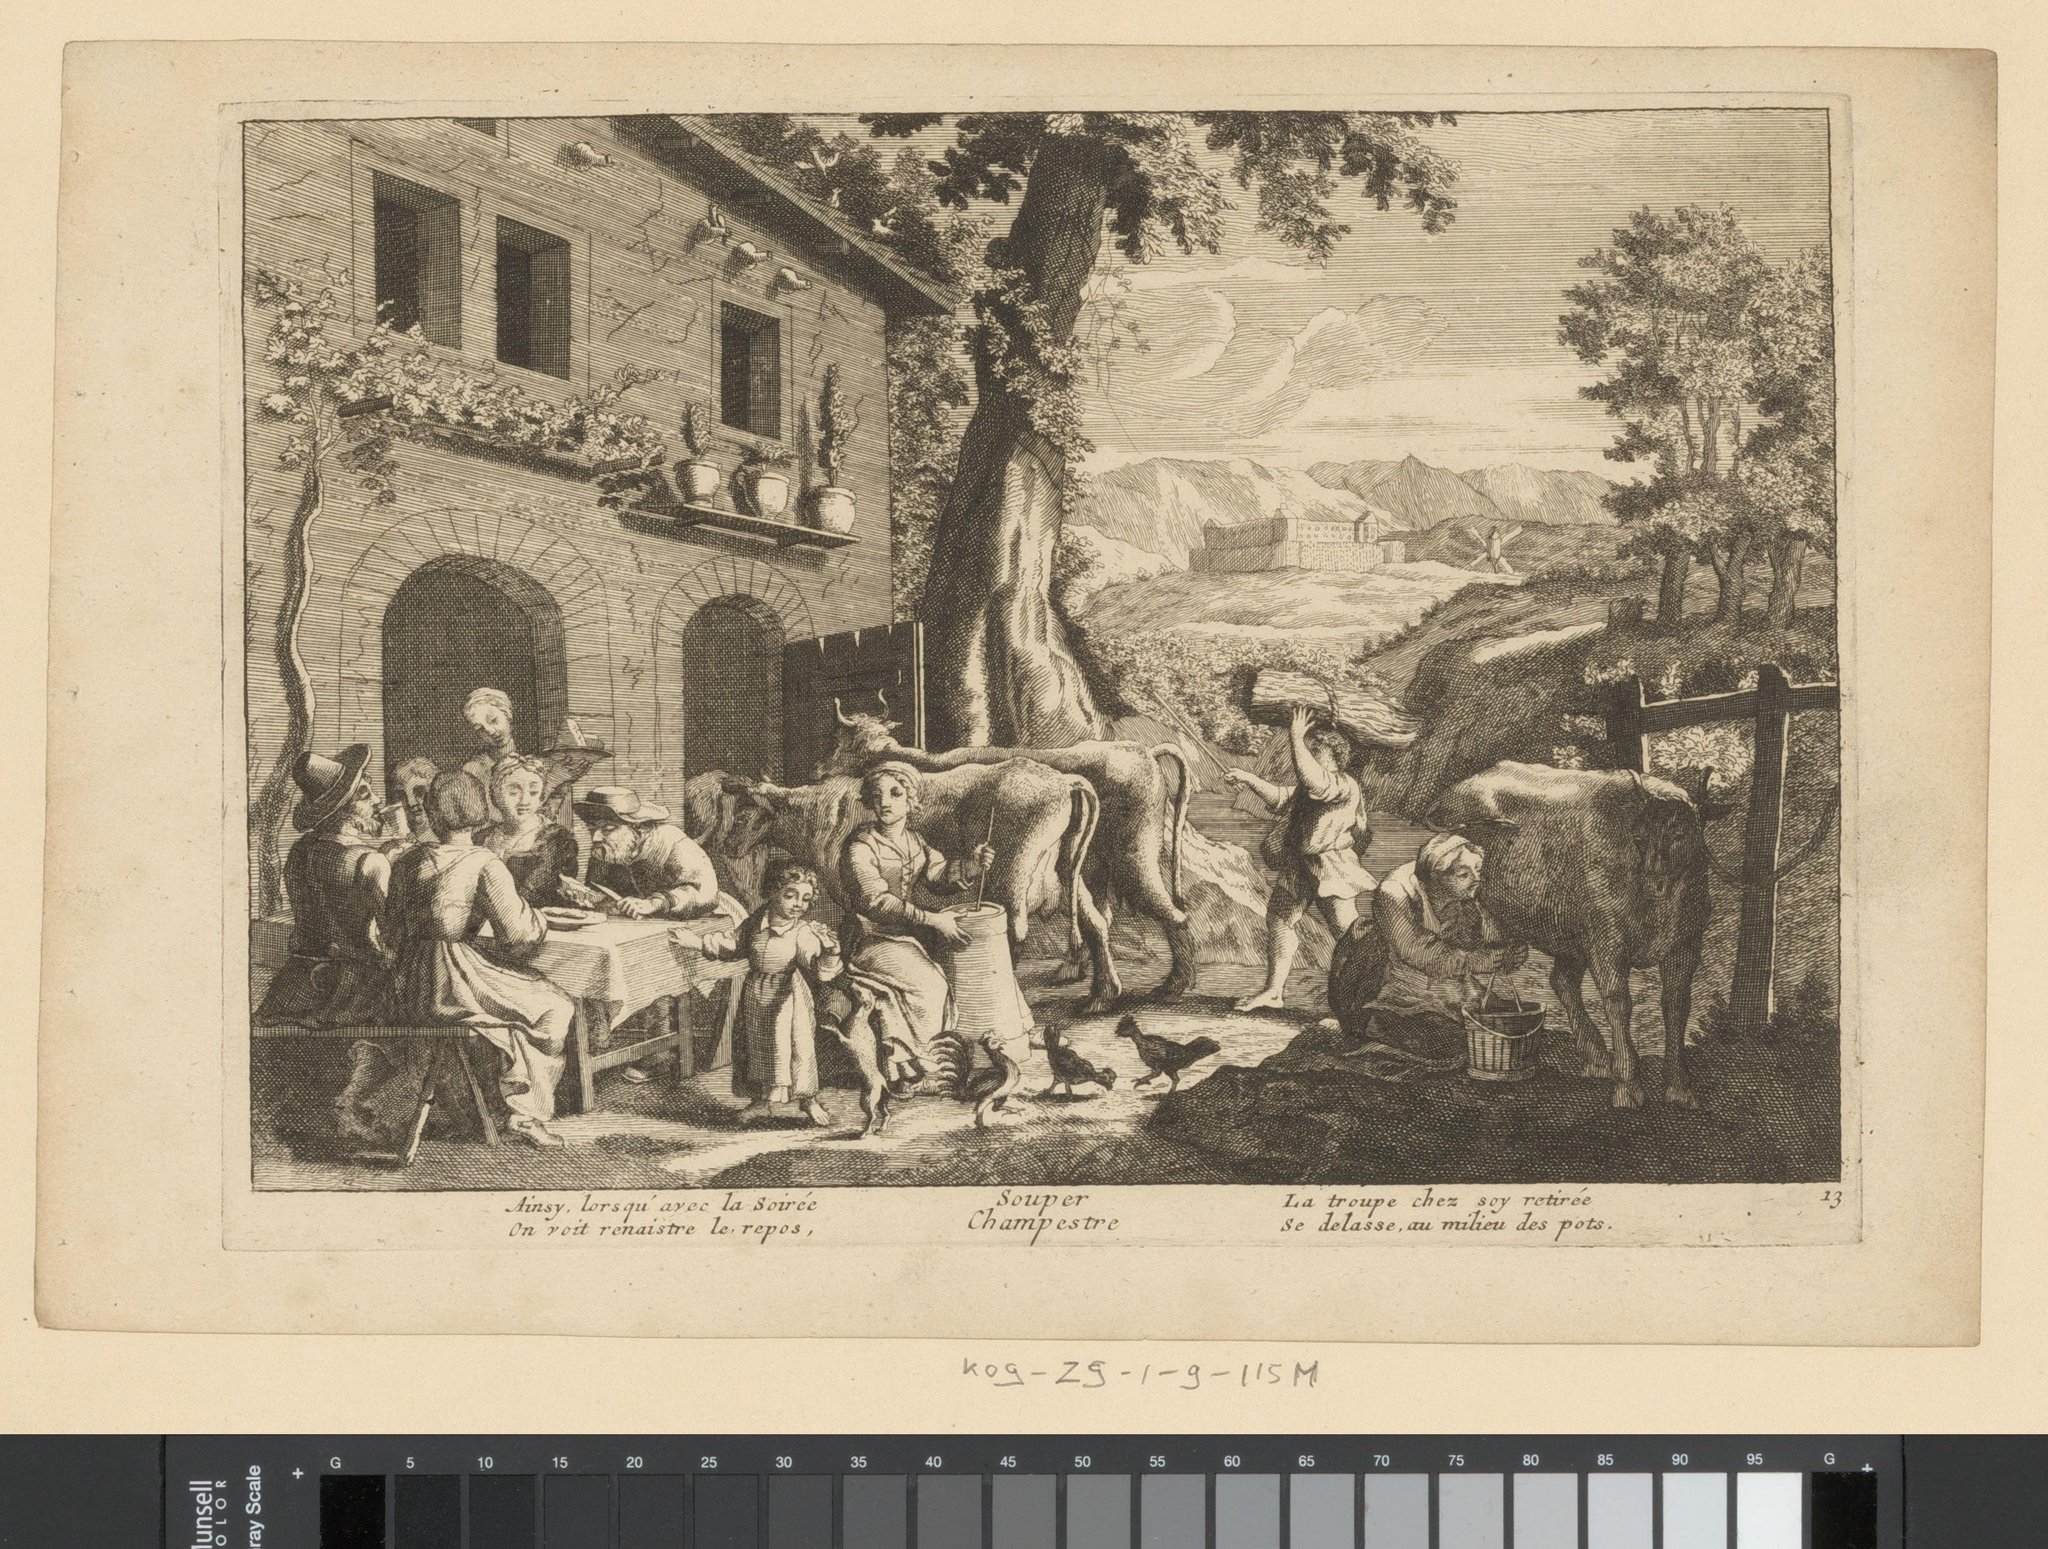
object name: print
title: Landelijke en pastorale scènes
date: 1670-1726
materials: paper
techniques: engraving, etching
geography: amsterdam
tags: evening meal, dinner, supper, milking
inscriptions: stamp:, collector's mark: Lugt 1641, collector's mark: Lugt 1641, stamp:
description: Onderaan genummerd: 13. Onderwerpsrubrieken binnen de Atlas Zeden en Gewoonten: Handel, nijverheid en verkeer, Boerenleven.